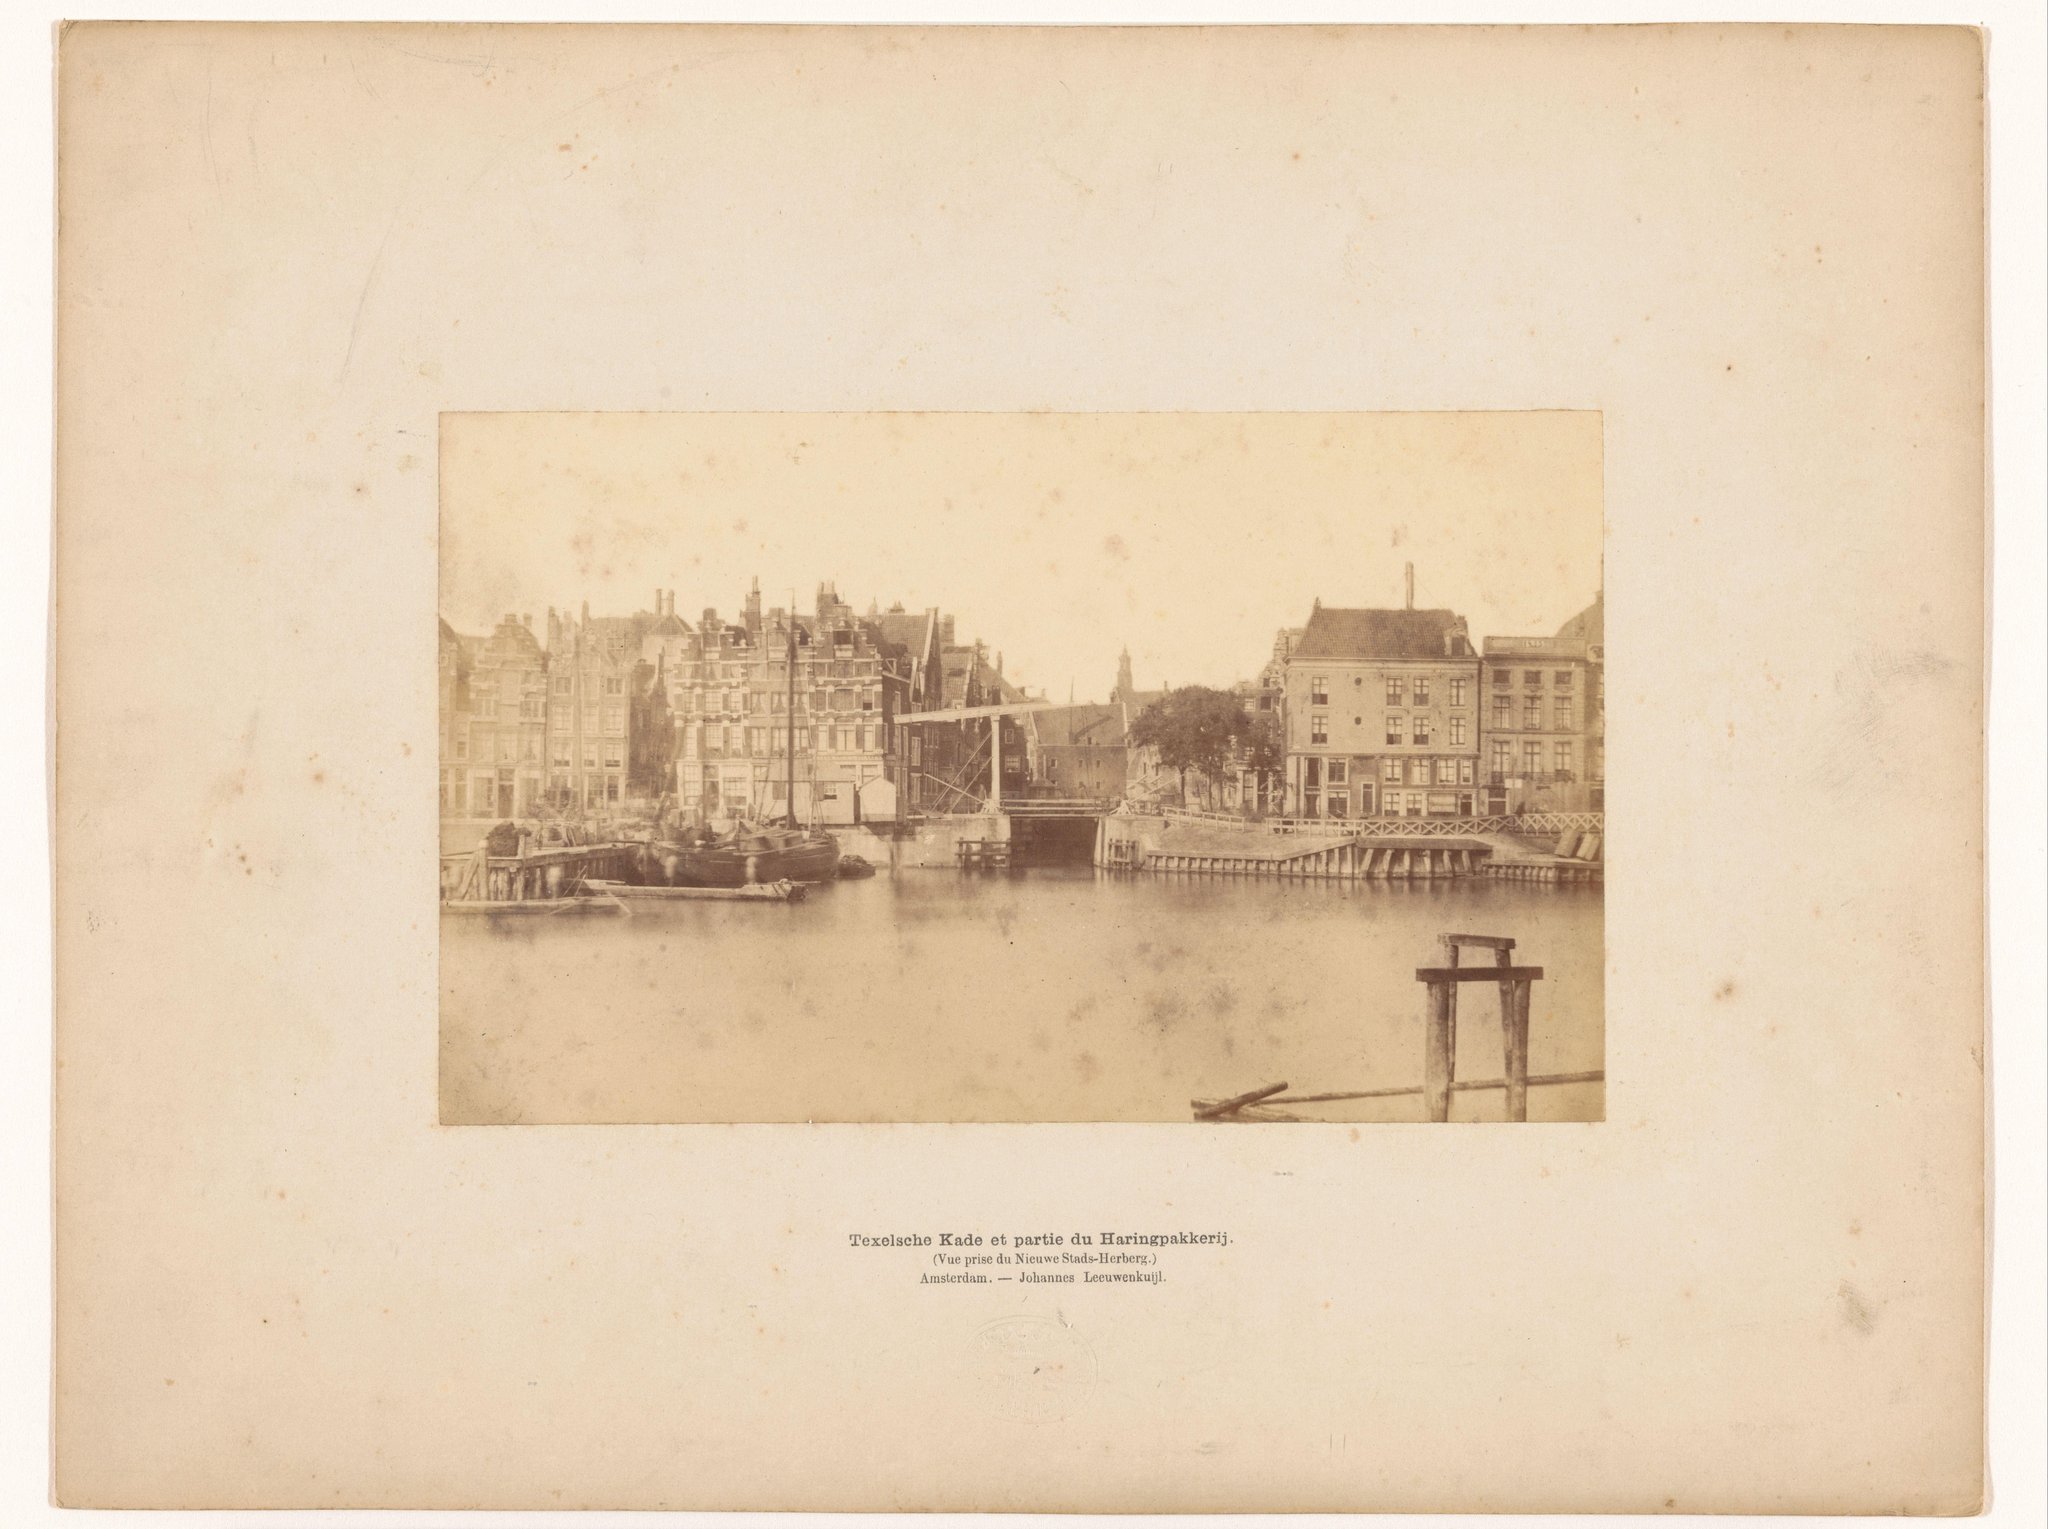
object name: photograph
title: Gezicht op de Texelsche Kade en de Haringpakkerij [tegenwoordig: Prins-Hendrikkade] vanaf de Nieuwe Stadsherberg in het IJ, Amsterdam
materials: cardboard, paper, photographic support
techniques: albumen print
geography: amsterdam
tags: street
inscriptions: annotation: ‘Texelsche kade et partie du Haringpakkerij. (vue prise du Nieuwe Stads-Herberg) Amsterdam. - Johannes Leeuwenkuijl’, stamp: ‘E & M Photographie...’